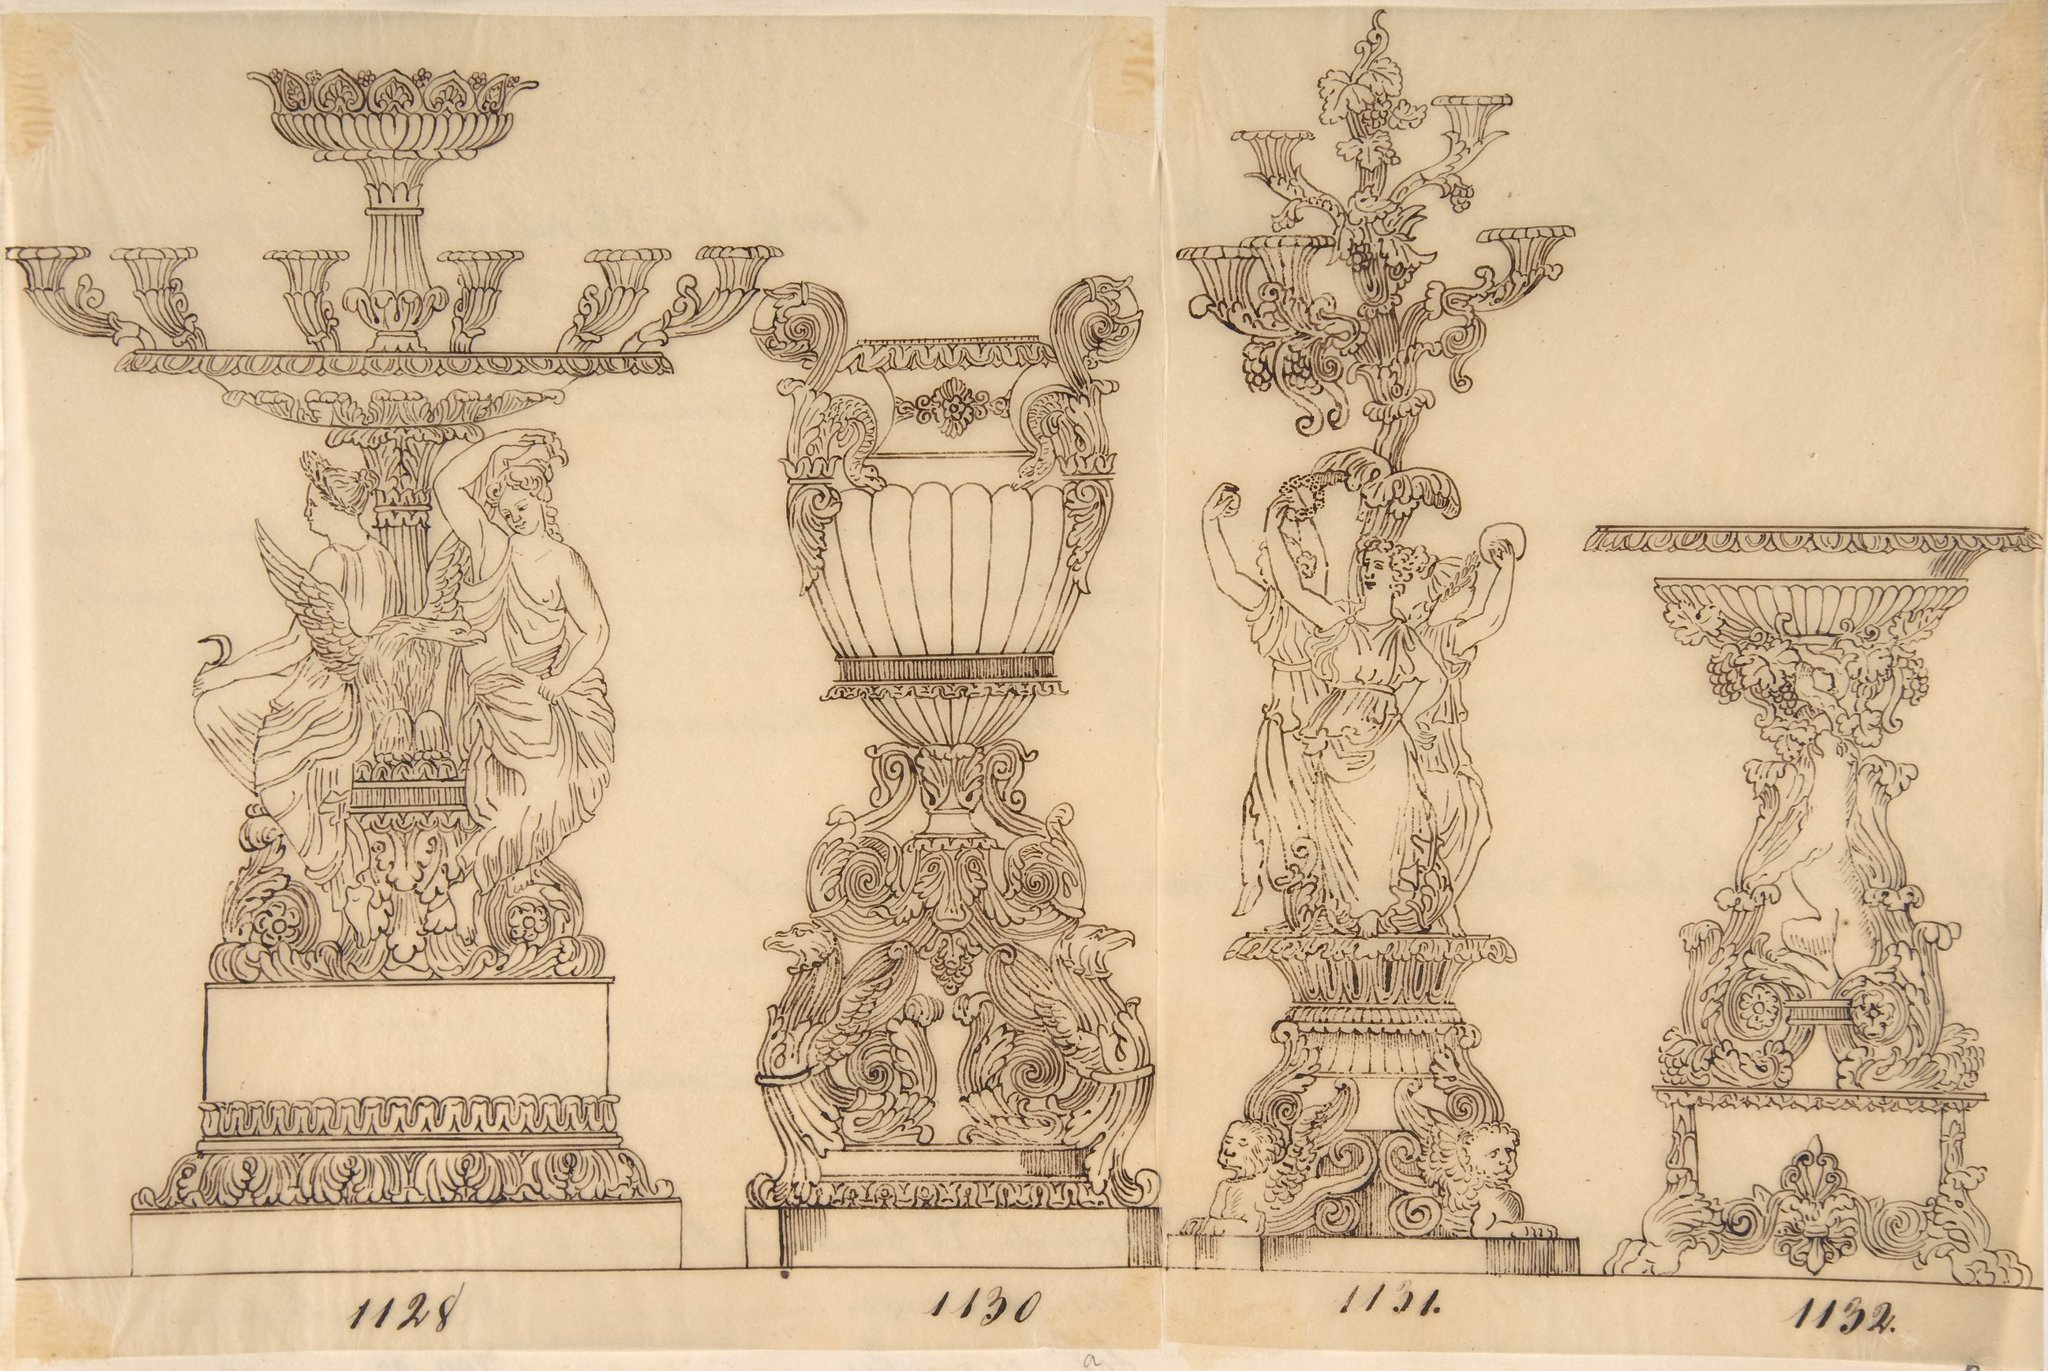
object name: drawing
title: Designs for Two Candelabras and Two Urns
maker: anonymous, french, 19th century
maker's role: artist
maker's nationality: french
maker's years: 1800-1900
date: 1801-1900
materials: ink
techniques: pen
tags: eagles,candelabra,urns